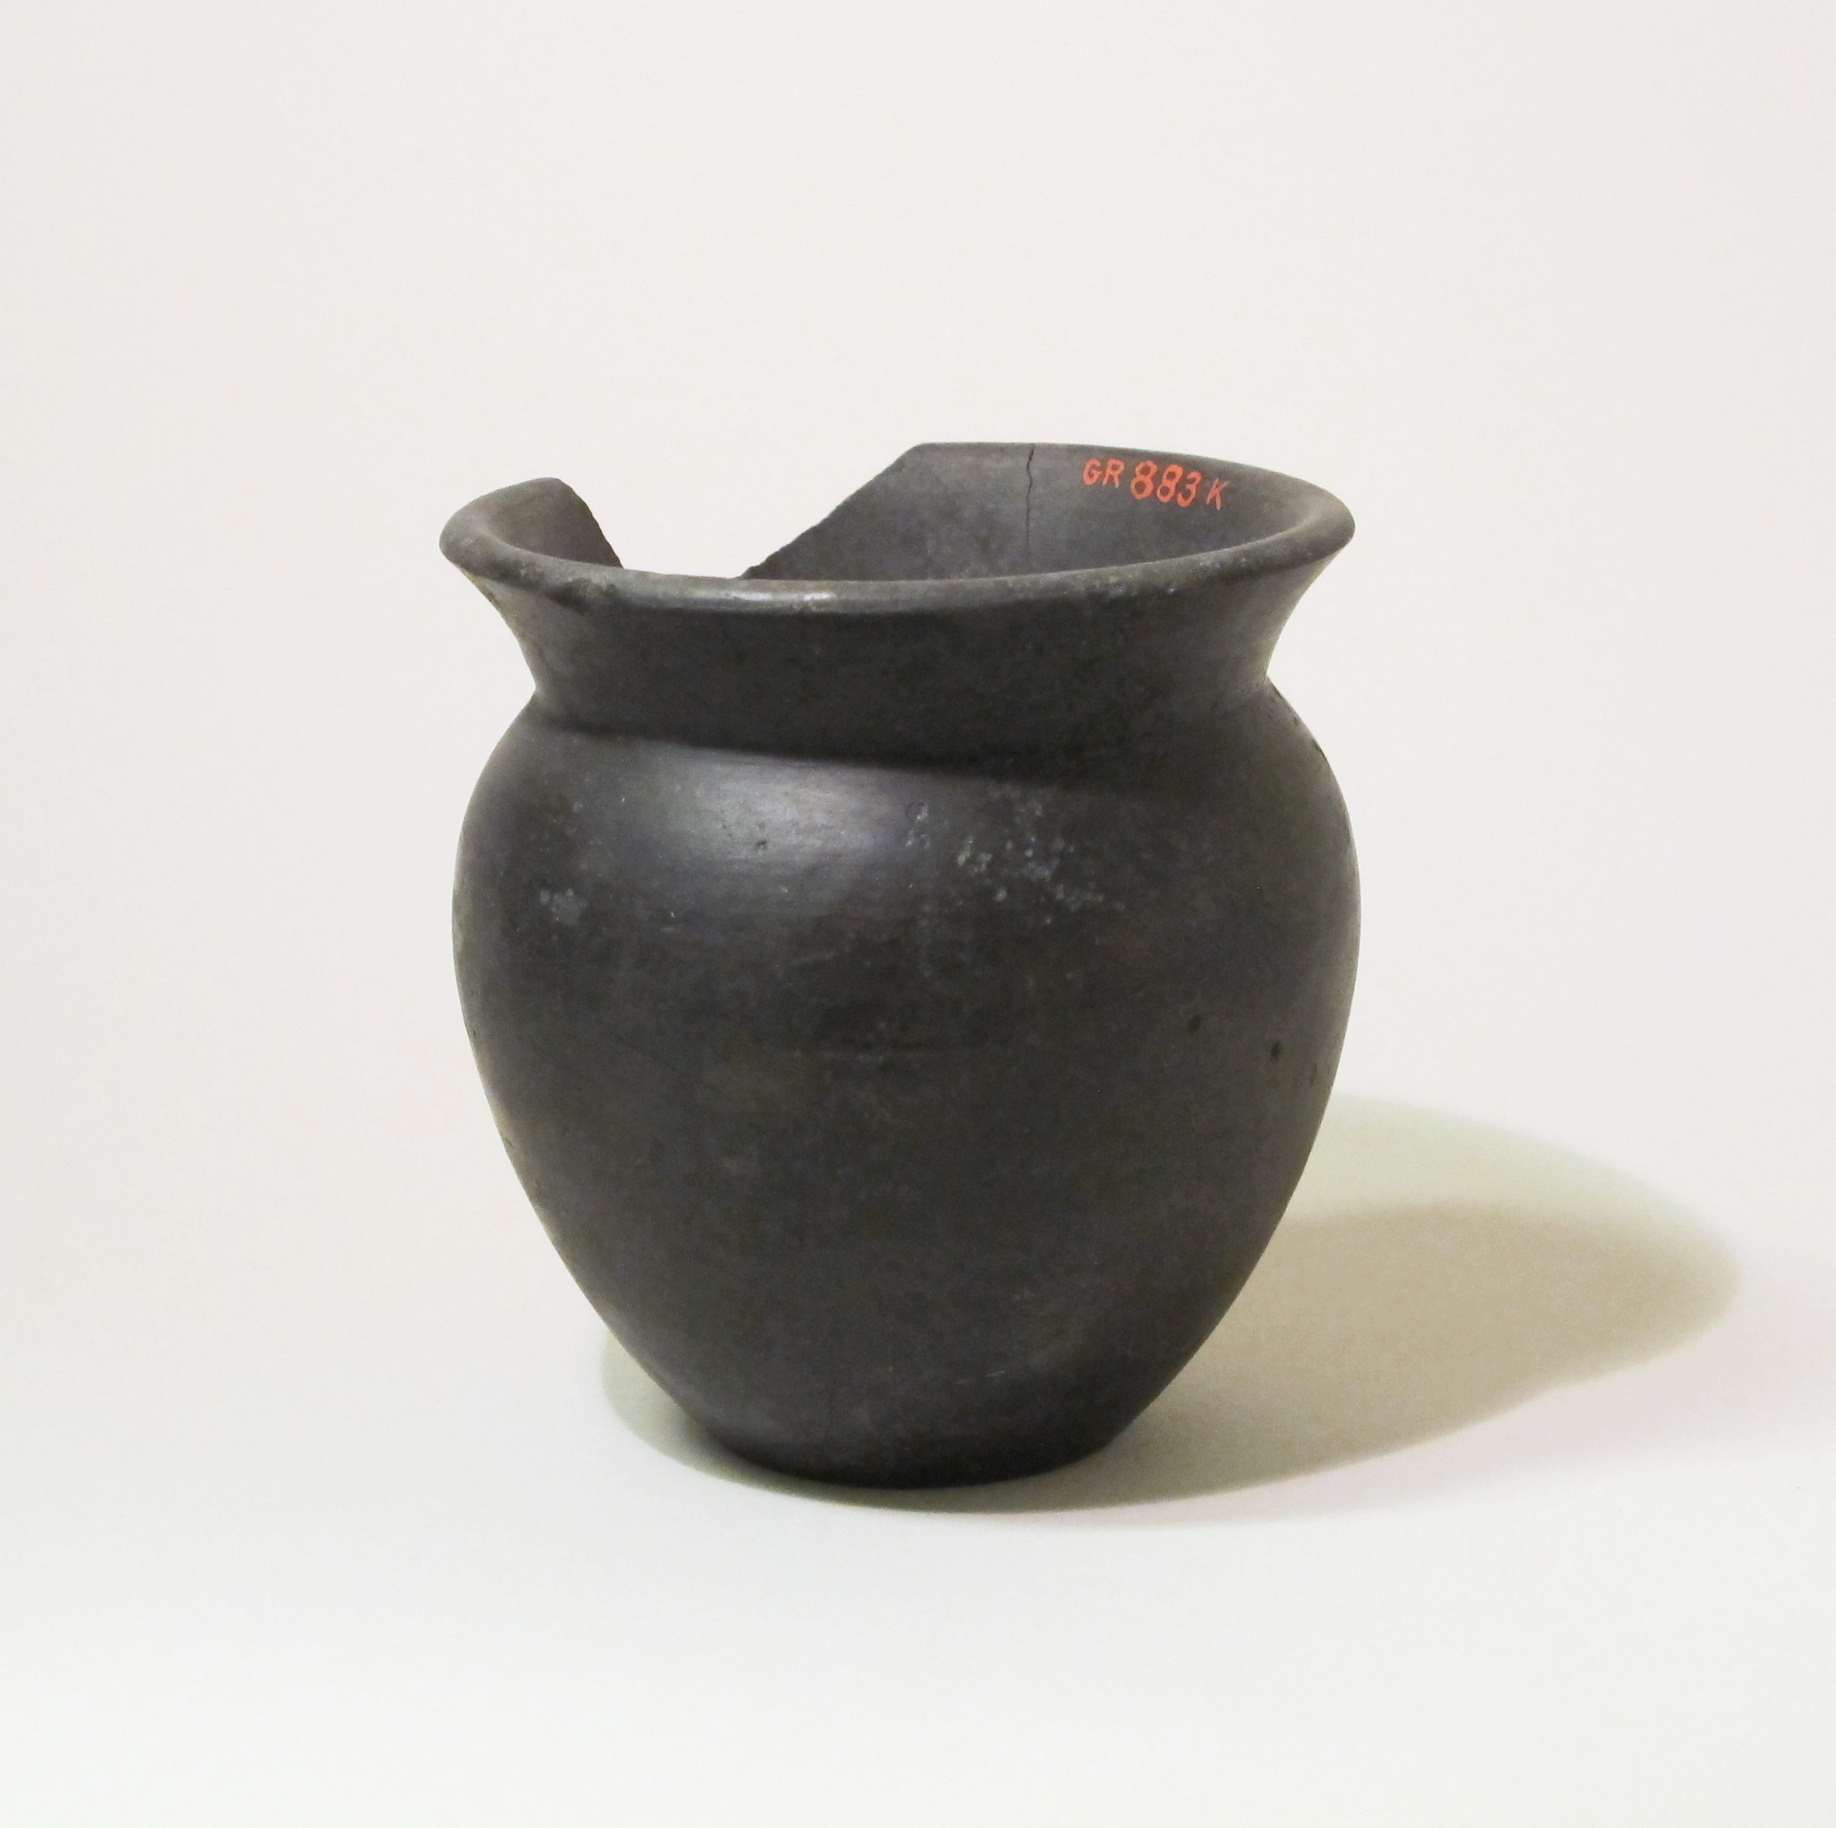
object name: focolare bowl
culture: etruscan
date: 550-501 BCE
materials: terracotta